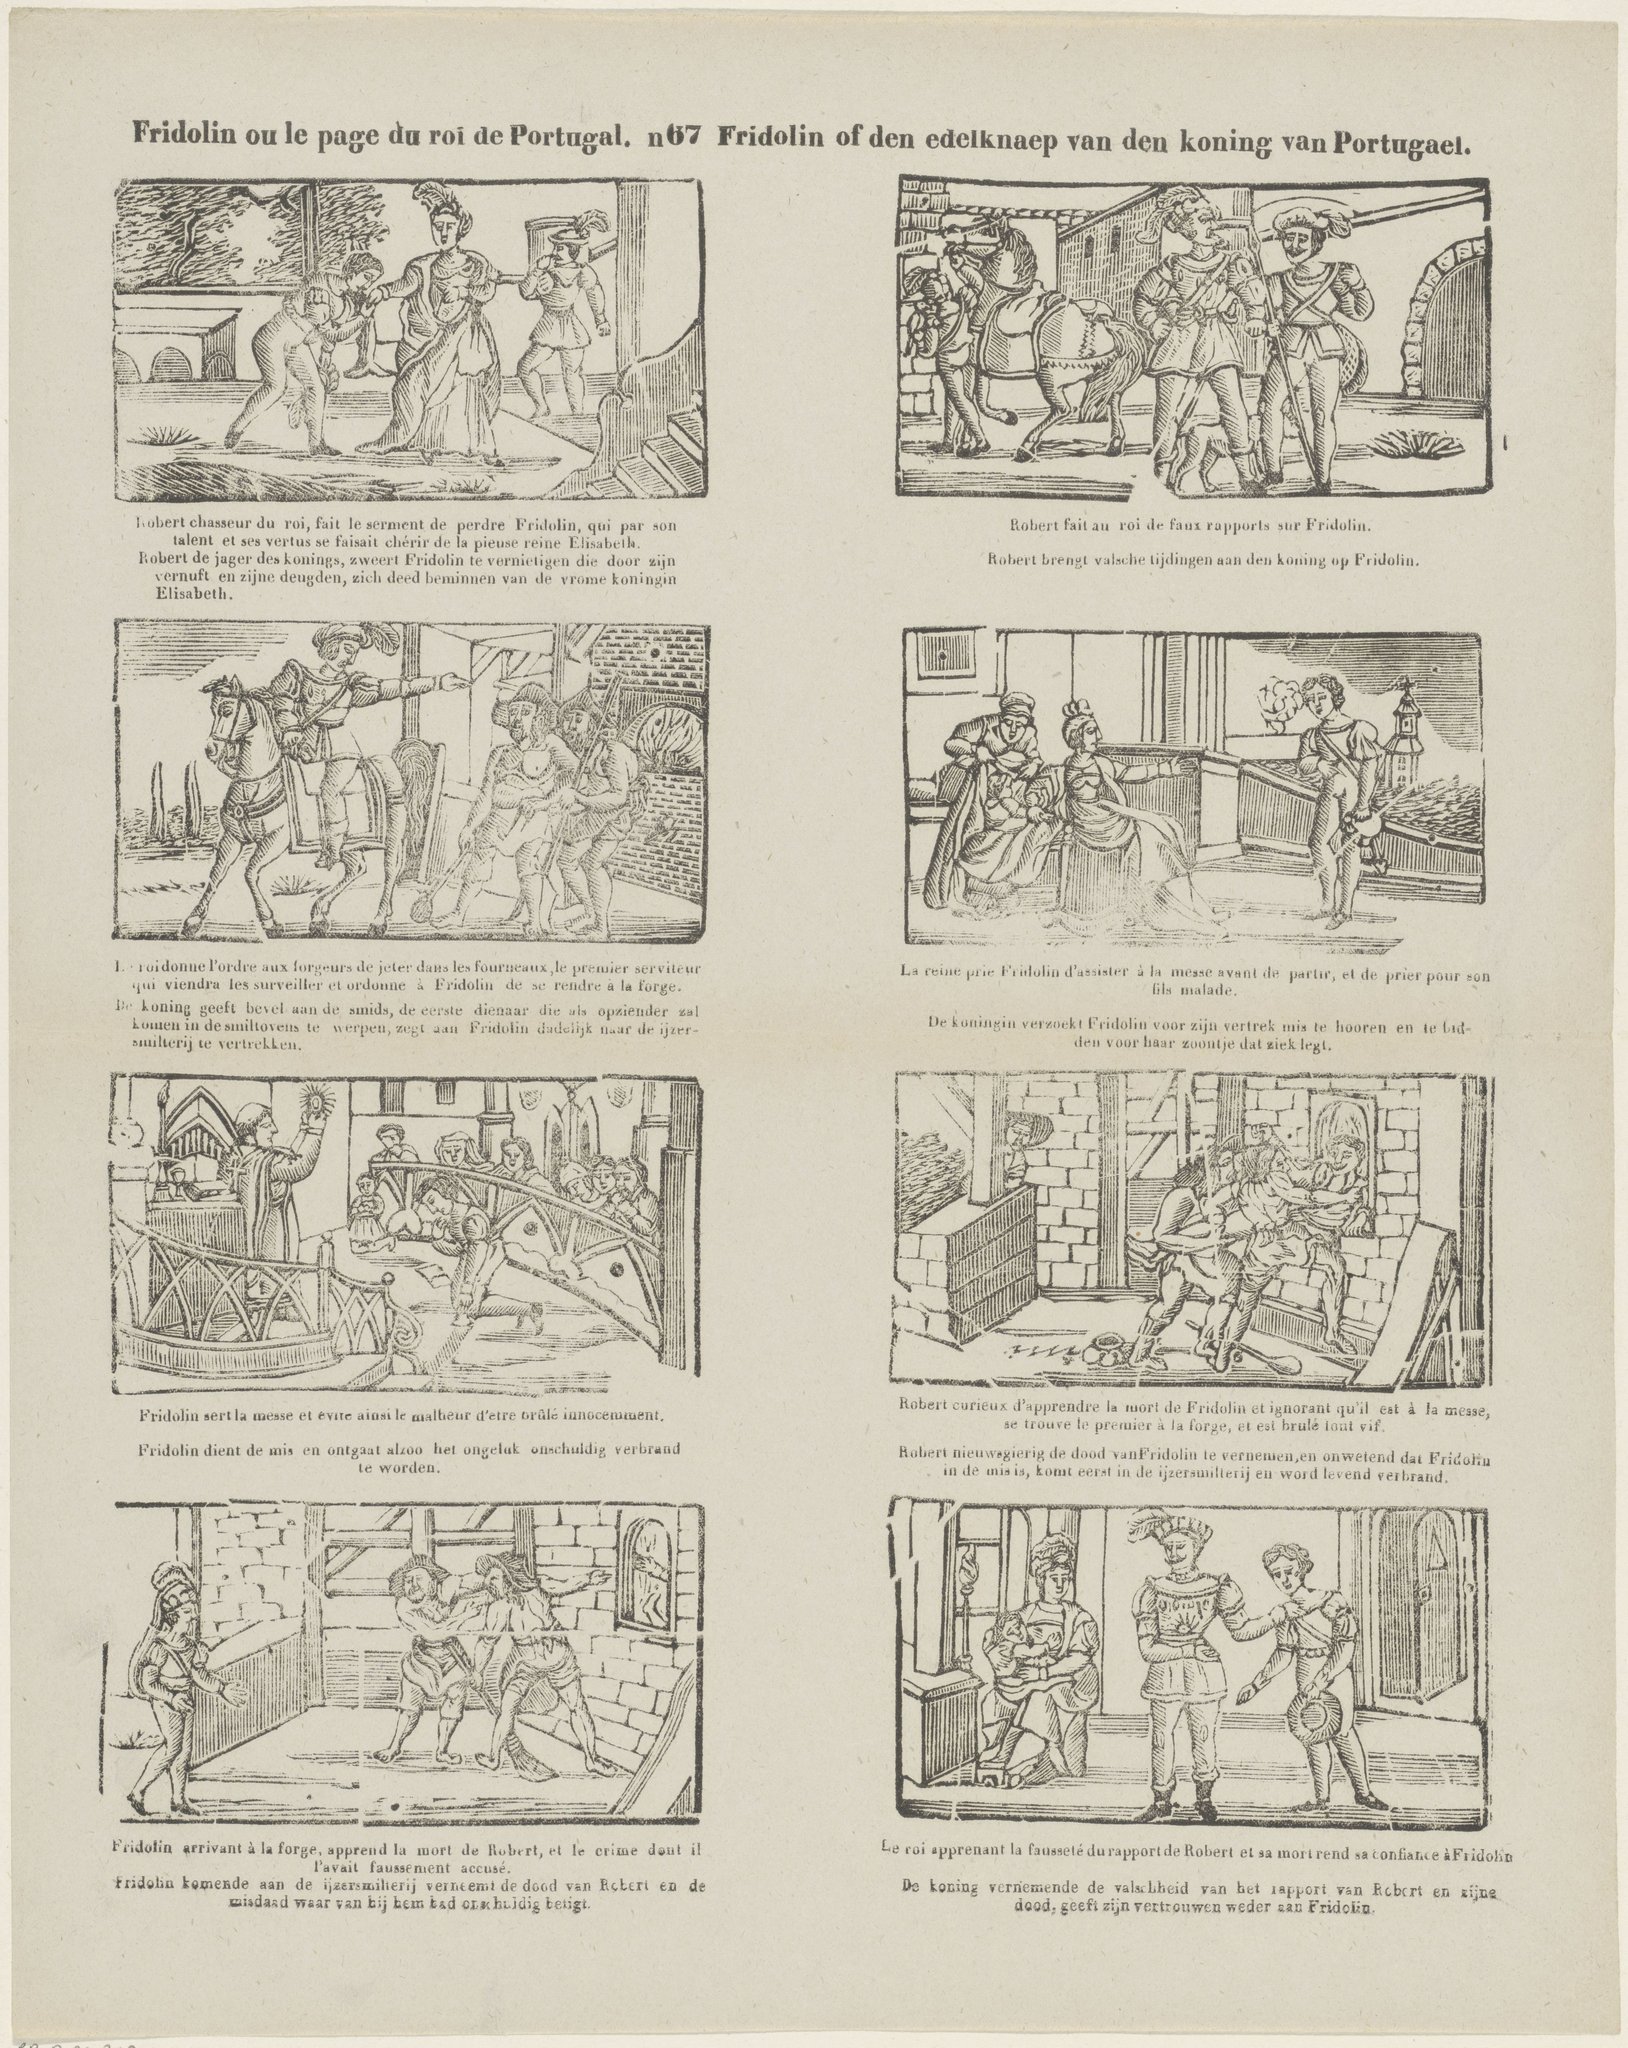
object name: print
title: Fridolin ou le page du roi de Portugal / Fridolin of den edelknaep van den koning van Portugael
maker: Anonymous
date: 1856-1900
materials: paper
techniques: letterpress printing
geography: netherlands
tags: tales and fairy tales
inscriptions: collector's mark: Lugt 2760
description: Blad met 12 voorstellingen uit het verhaal van Fridolin, die door Robert vals wordt beschuldigd. De koning van Portugal beveelt de smid de eerste persoon die binnenkomt in de oven te werpen, en stuurt Fridolin naar hem toe. Maar deze ontkomt doordat hij eerst naar de mis gaat. Robert ondergaat Fridolins lot. Onder elke afbeelding een onderschrift in het Nederlands en in het Frans. Genummerd midden boven: n 67.